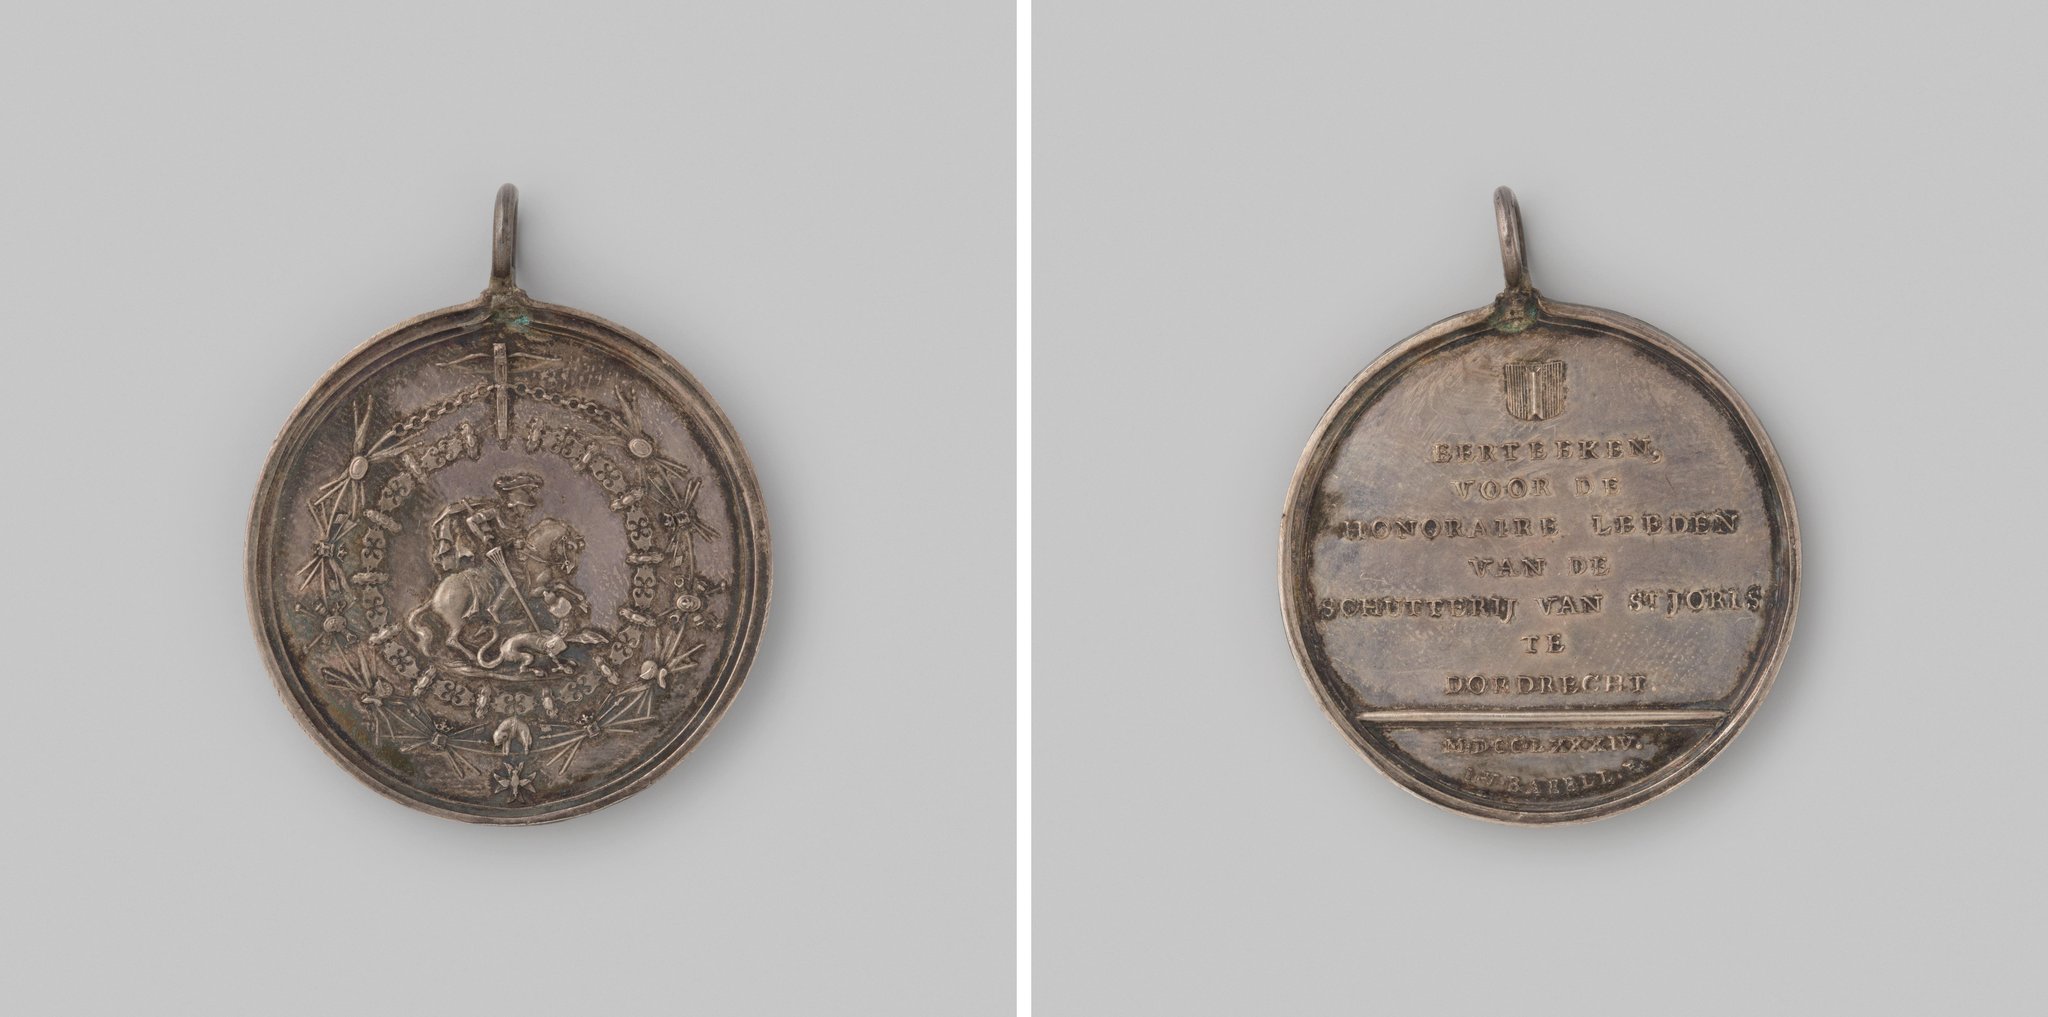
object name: history medal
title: Ereteken voor de honoraire leden van de schutterij Sint Joris te Dordrecht 1784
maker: johannes josephus van baerll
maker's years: 1764-1799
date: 1784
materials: silver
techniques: pressing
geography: dordrecht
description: Zilveren penning aan draagoog, op de voorzijde Sint Joris vechtend met de draak omringd door ketens van de Orden van het Gulden Vlies en van de Heilige Geest, beide hangend aan een voetboog bovenaan, op de keerzijde zeven regels tekst onder een Dordrechts wapenschild.